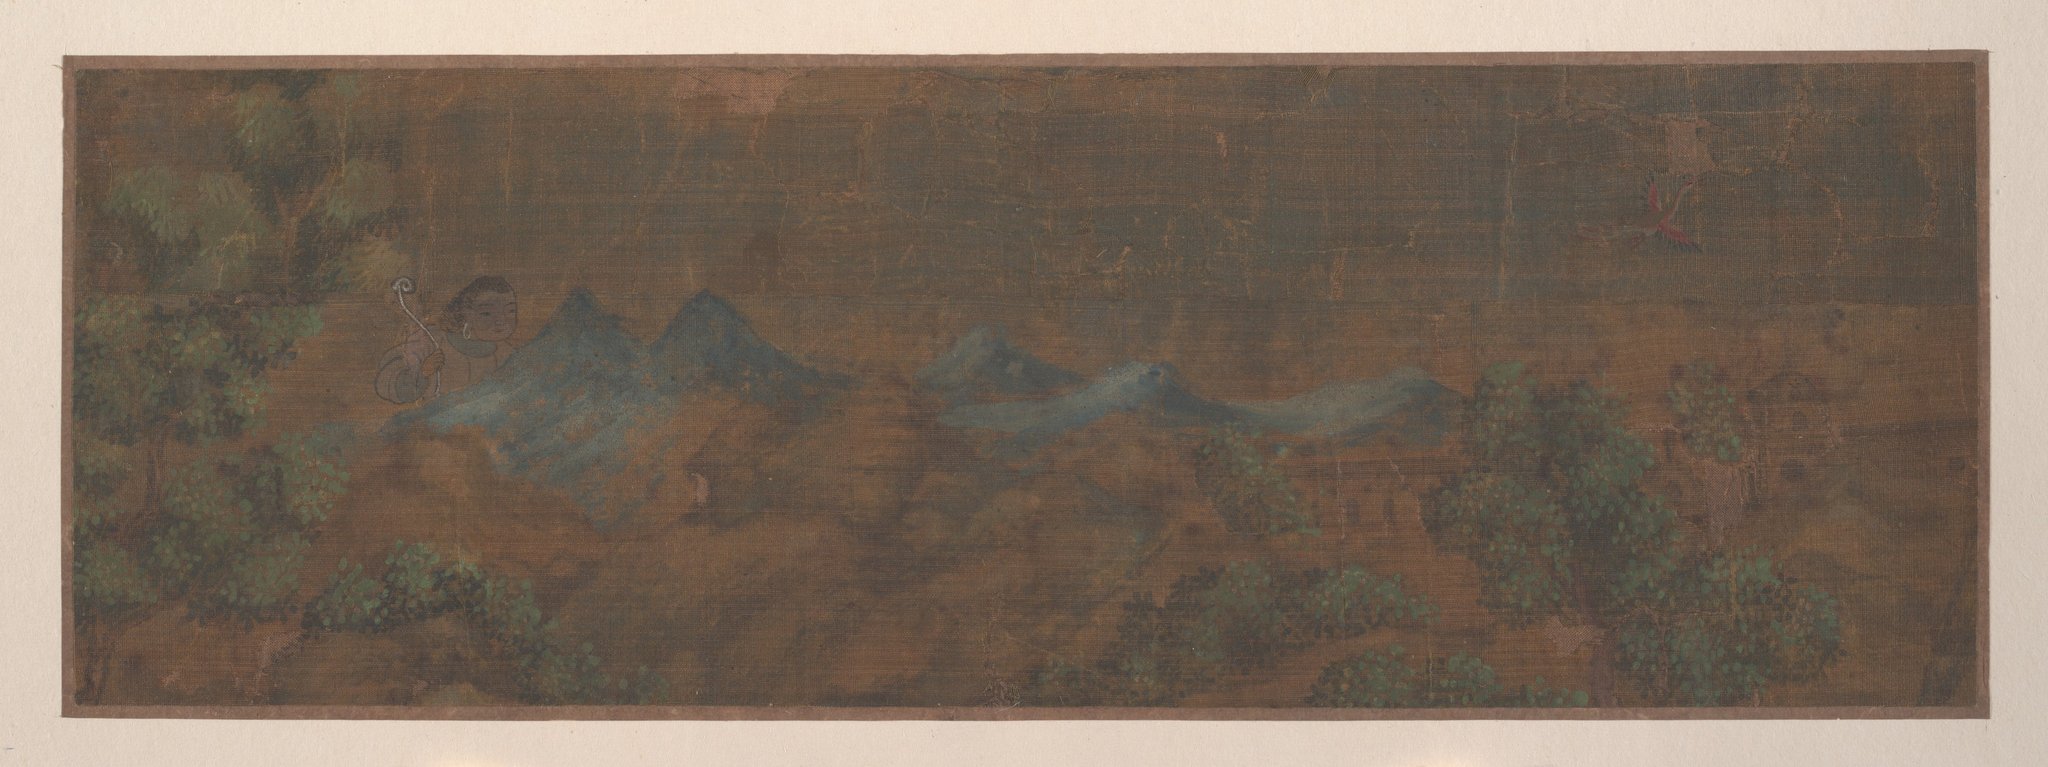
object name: album leaf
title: Landscape Painting of Figure in Woodland Setting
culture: chinese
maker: unidentified artist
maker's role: artist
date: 1644-1911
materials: silk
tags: landscapes